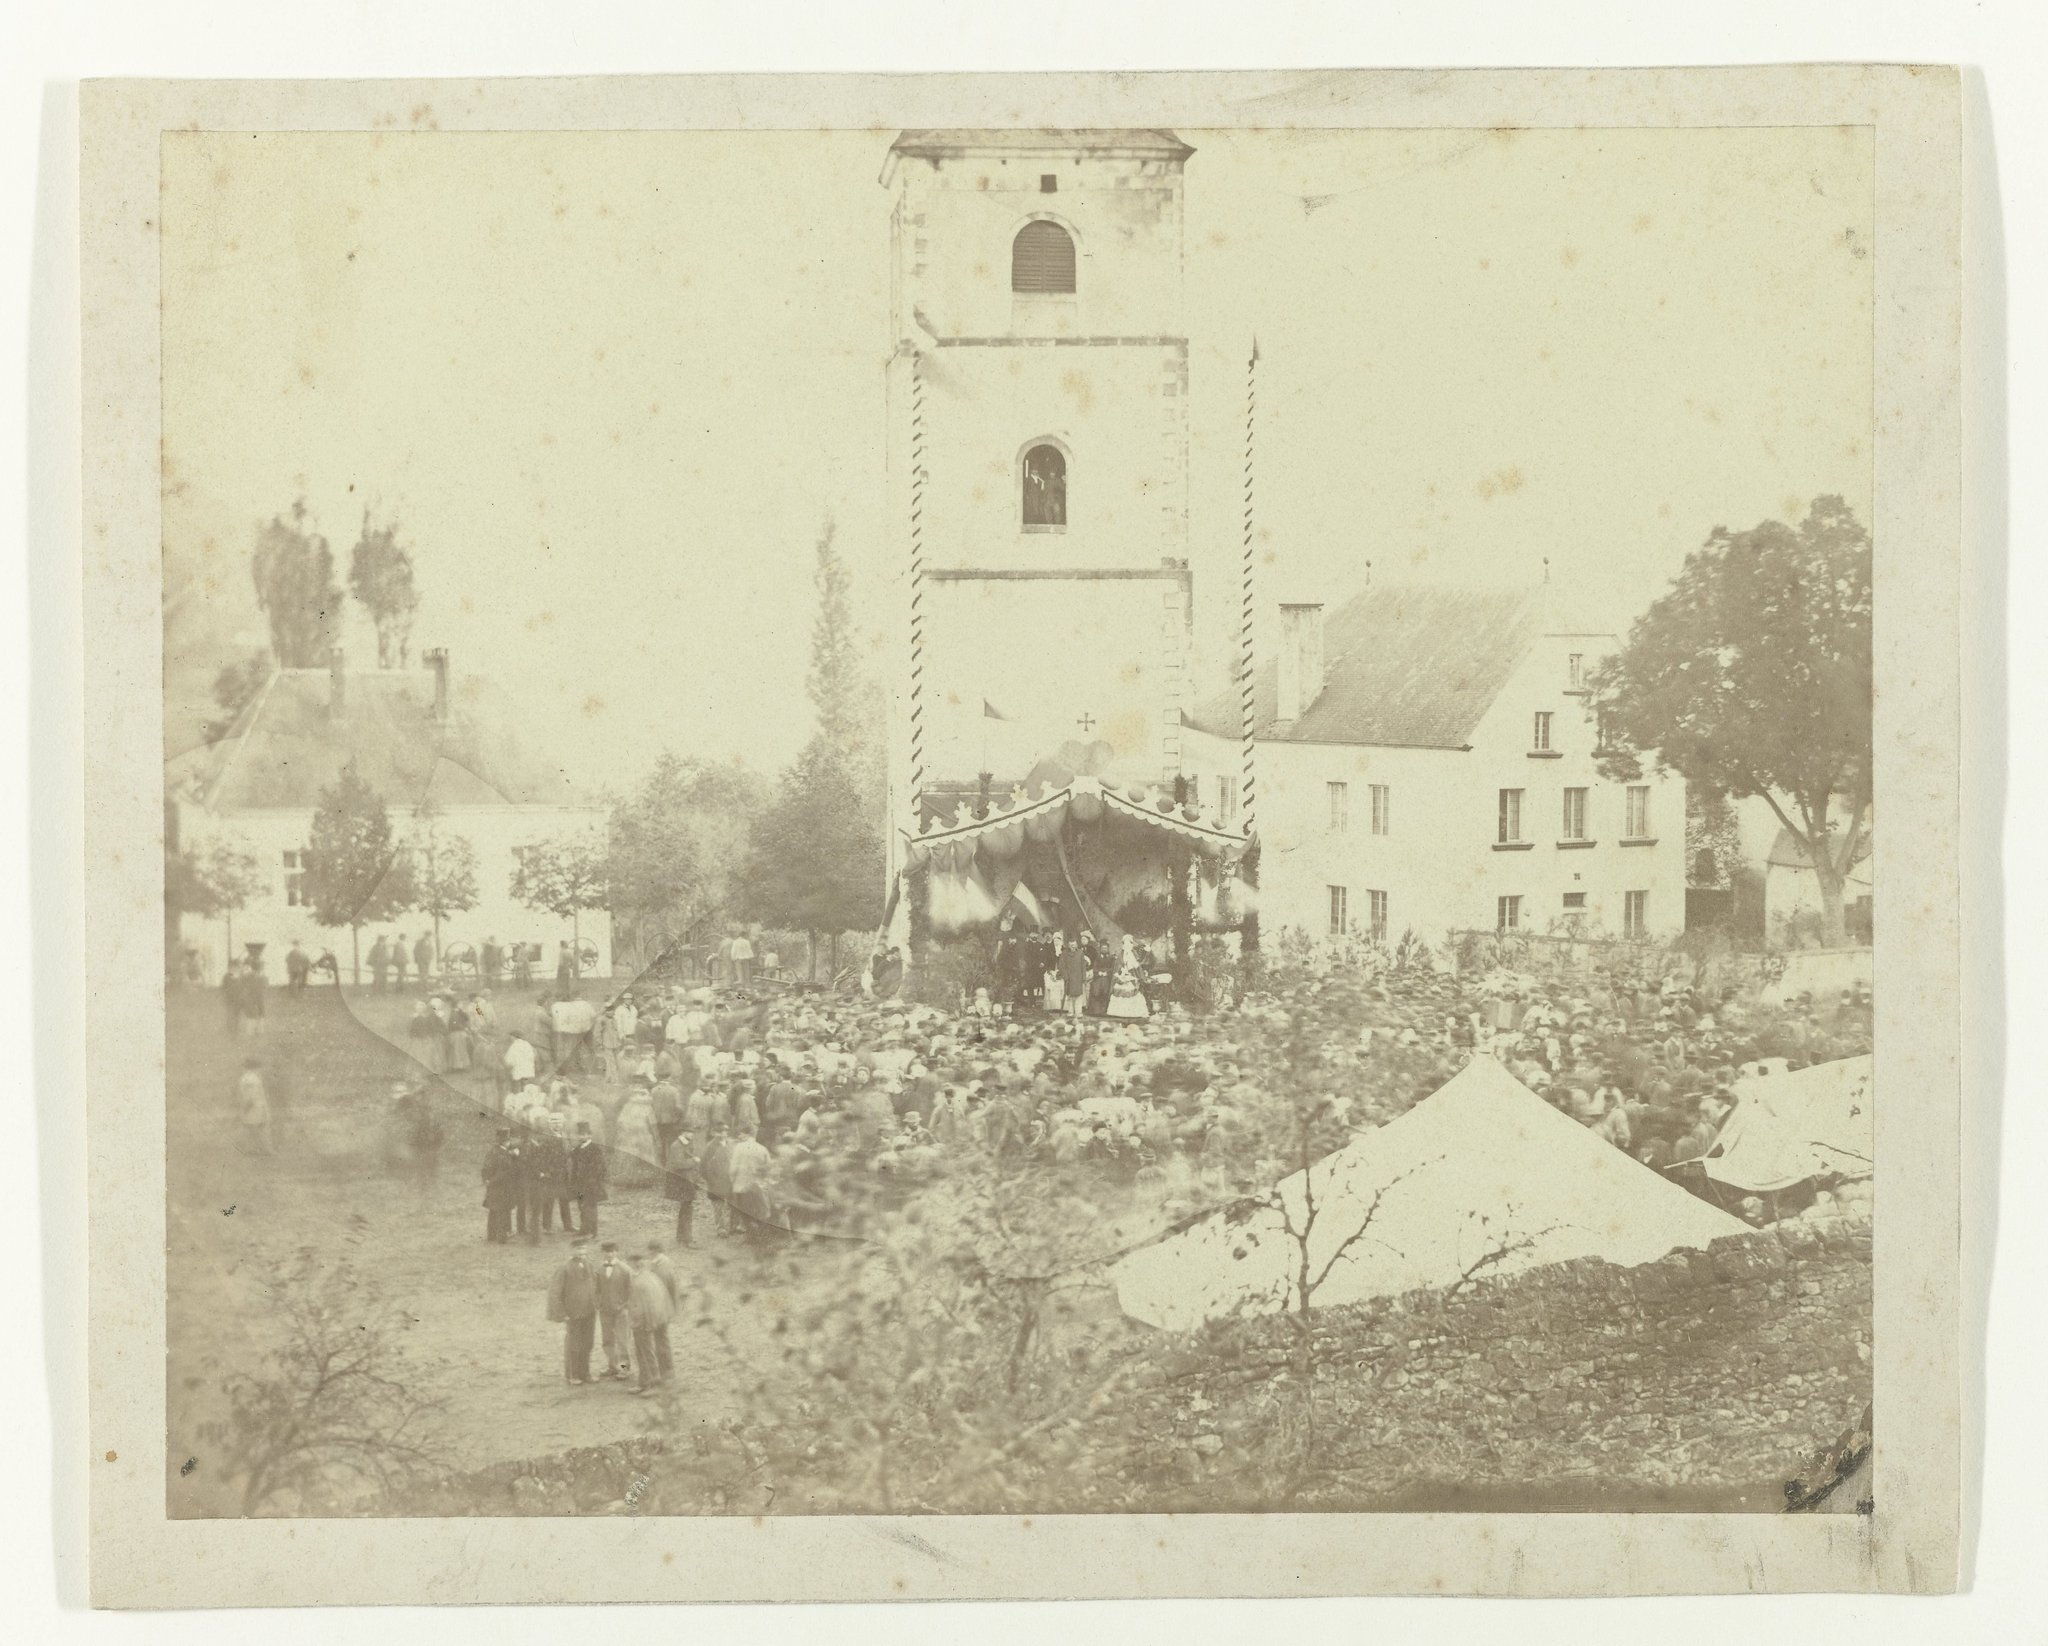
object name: photograph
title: Gezicht op menigte bij feesttent voor een toren, op onbekende plek in Nederland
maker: Anonymous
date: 1865-1870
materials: cardboard, paper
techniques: albumen print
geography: netherlands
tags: festivities